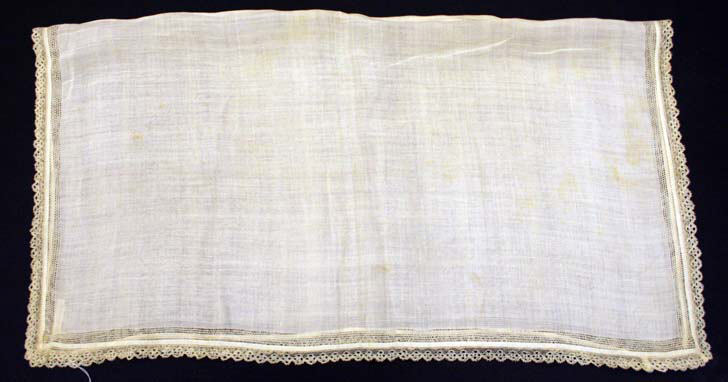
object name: handkerchief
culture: american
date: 1842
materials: cotton, linen